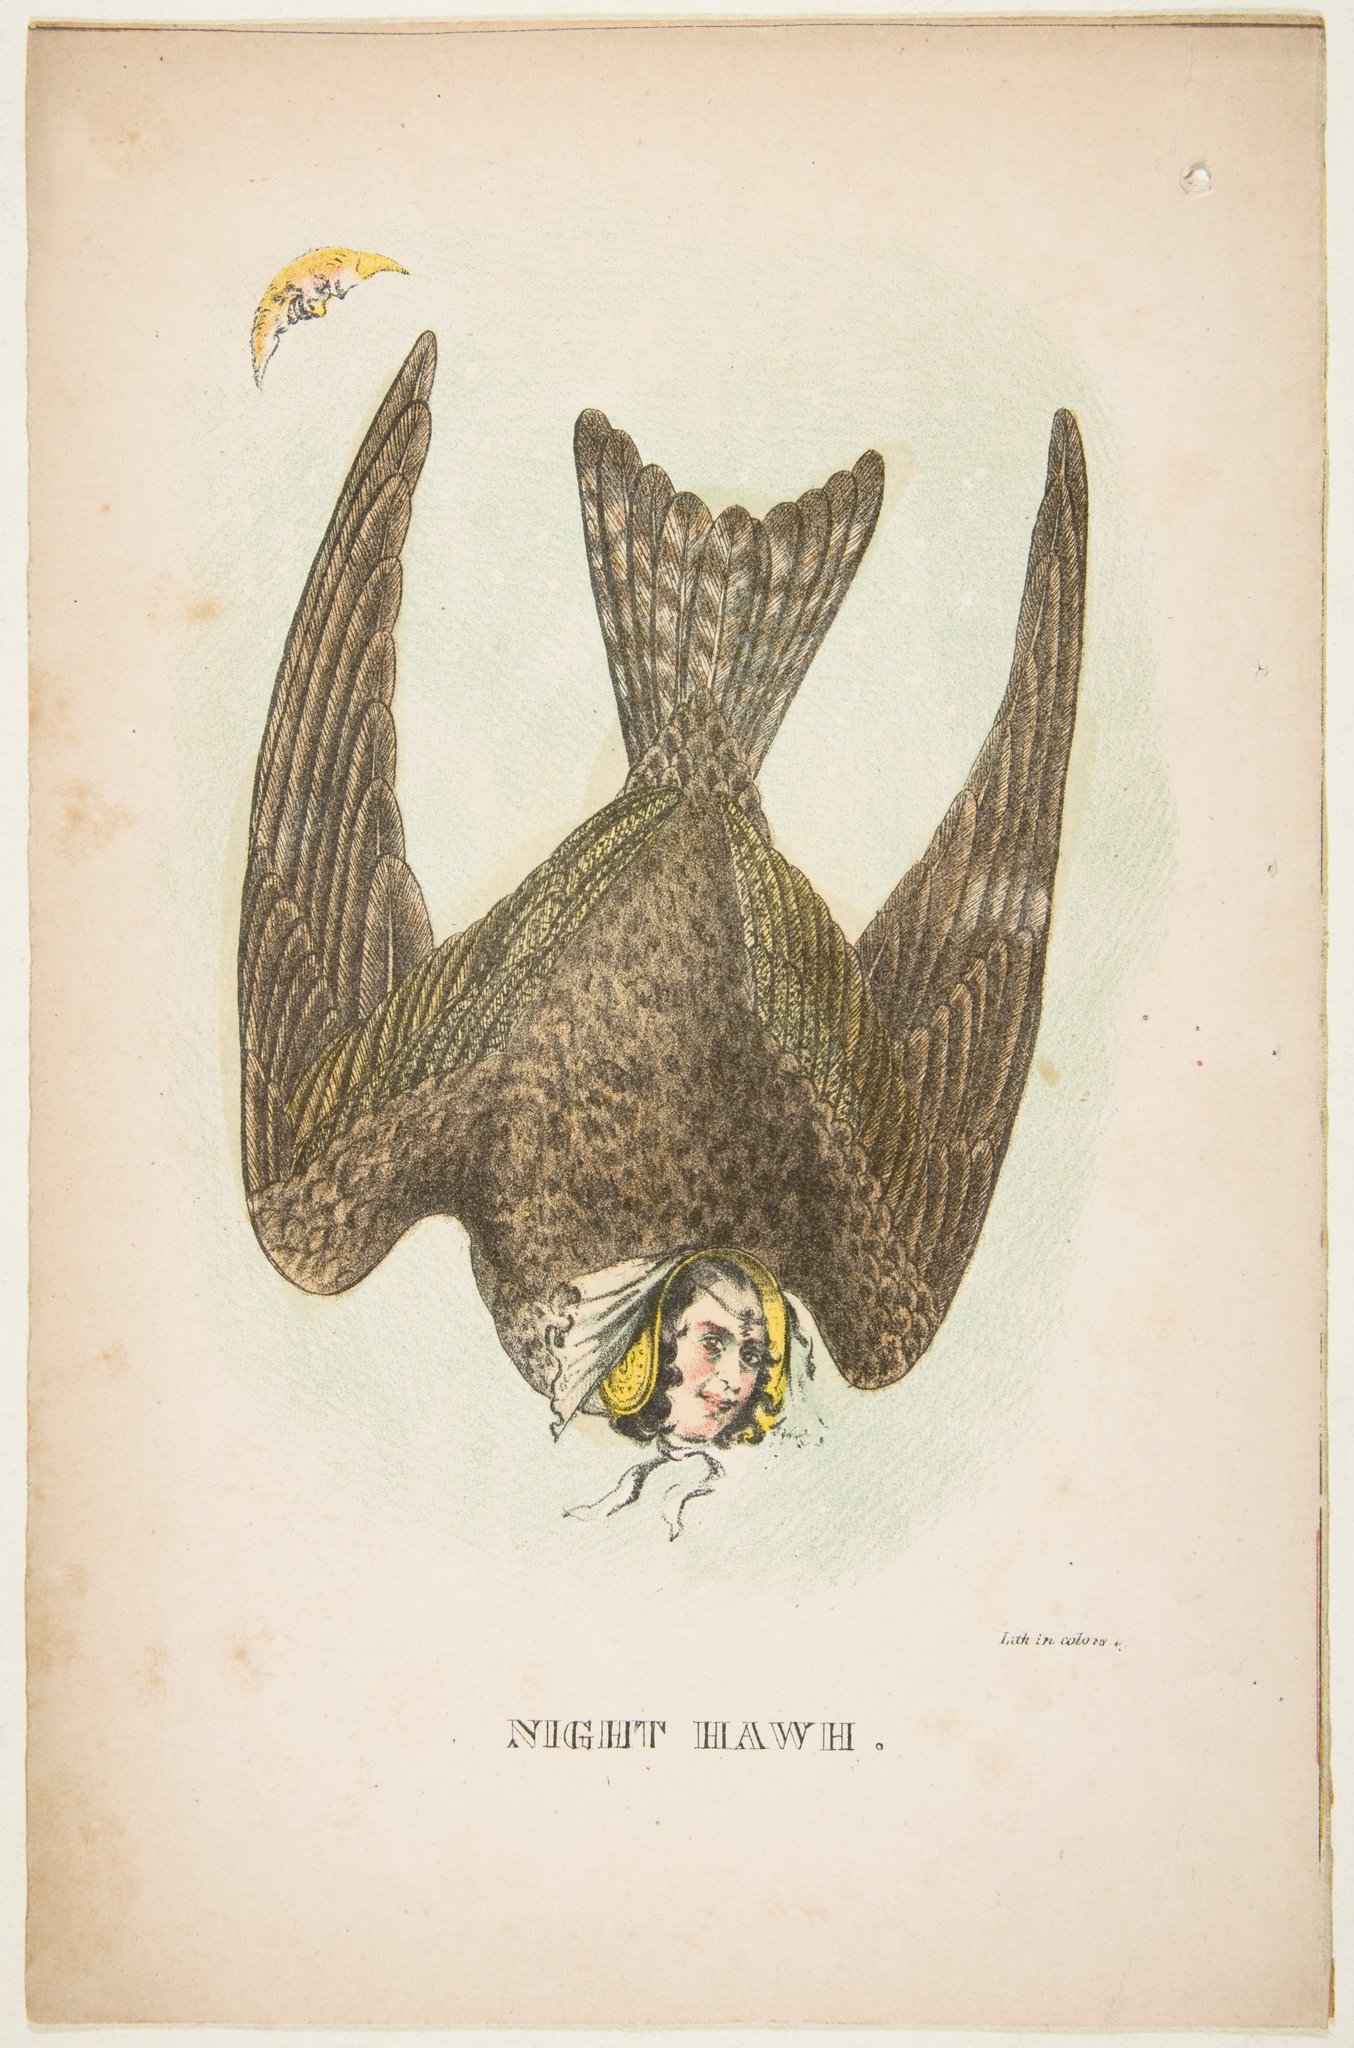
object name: print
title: Night Hawk, from "The Comic Natural History of the Human Race"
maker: henry louis stephens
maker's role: artist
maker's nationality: american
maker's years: 1824-1882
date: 1851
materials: watercolor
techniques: lithograph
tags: satire